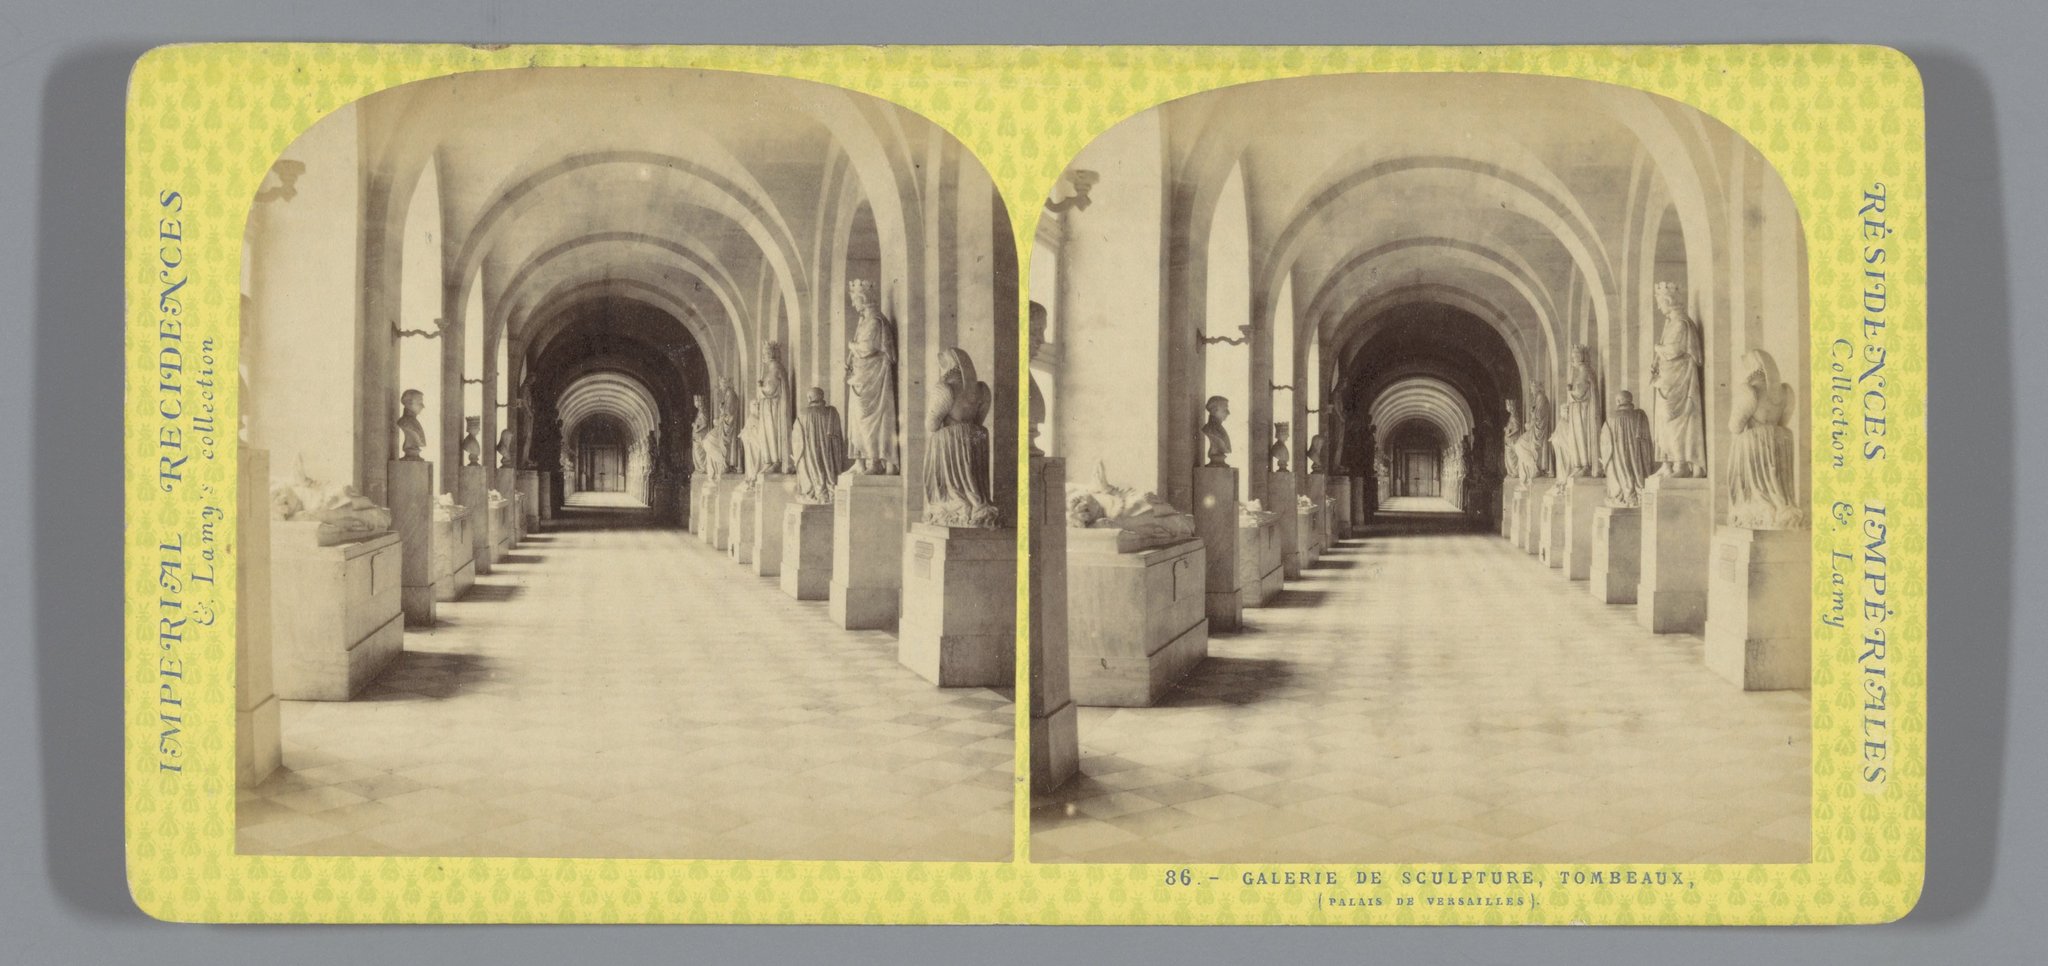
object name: stereograph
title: Beeldengalerij in het paleis van Versailles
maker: ernest eléonor pierre lamy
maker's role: publisher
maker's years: 1828-1900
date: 1860-1880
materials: cardboard, photographic support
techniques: albumen print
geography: versailles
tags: gallery of sculptures, interior ~ representation of a building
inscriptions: inscription: ‘E. Lamy's collection’, number: ‘86.’